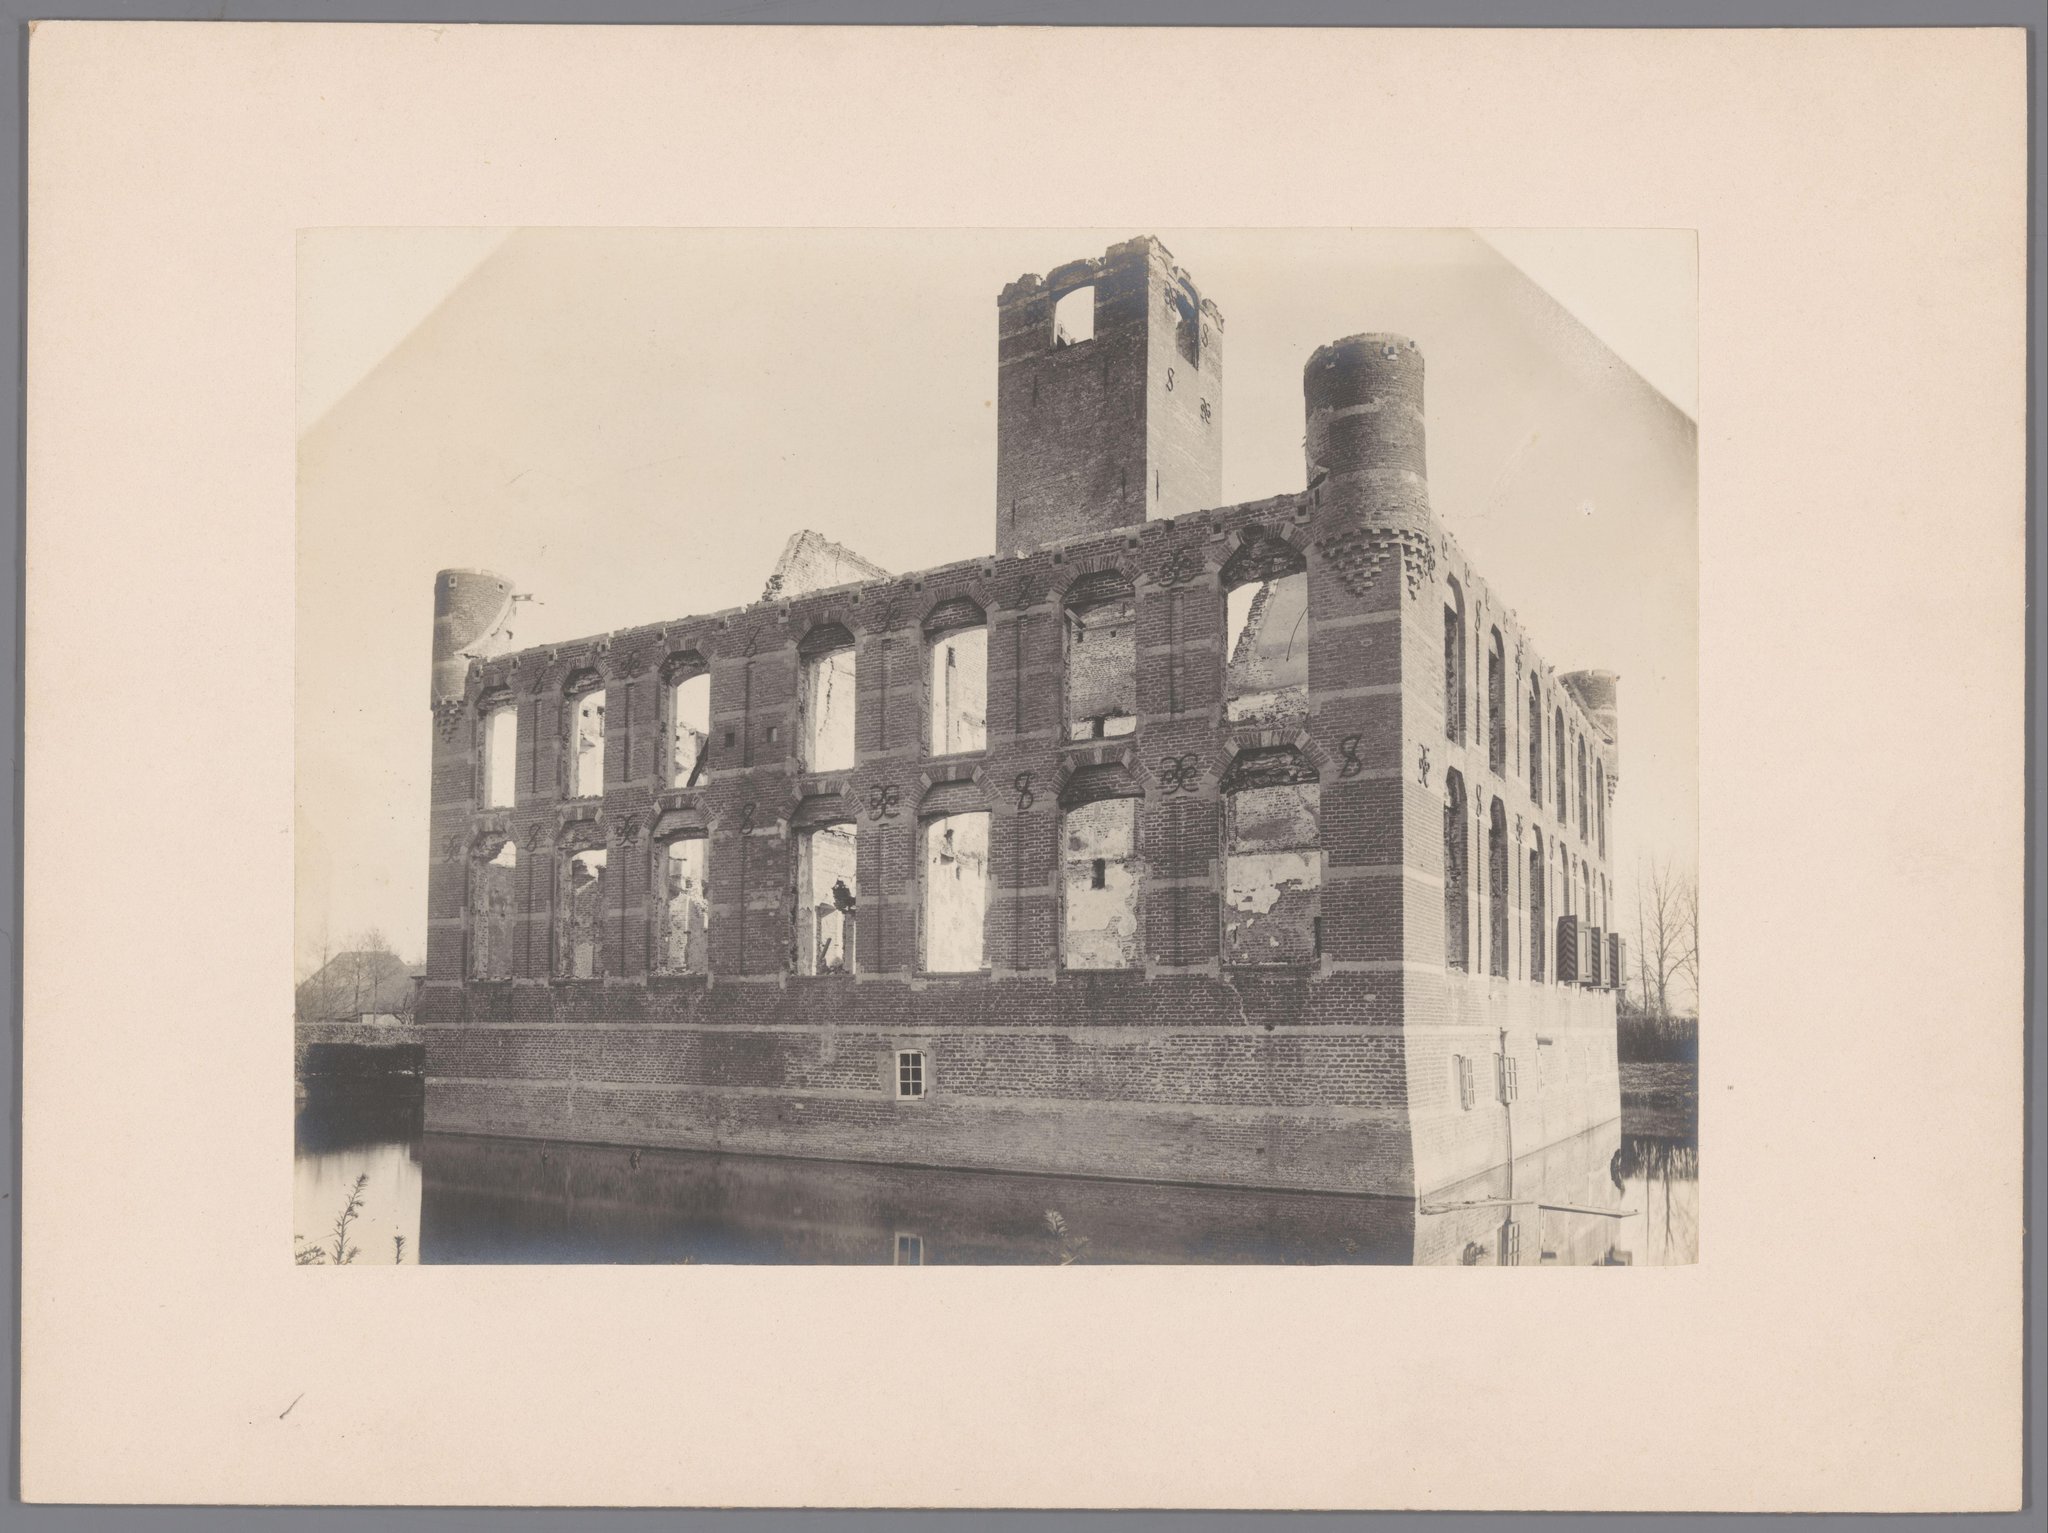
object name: photograph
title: Gezicht op het Kasteel van Wijchen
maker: anoniem (monumentenzorg)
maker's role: fotograaf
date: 1907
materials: cardboard, photographic support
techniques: gelatin silver print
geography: wijchen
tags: castle, landscape with tower or castle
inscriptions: annotation: ‘Kasteel te Wijchen achtergevel (G.)/ afgebrand Dec. 1906/ gephoto. Feb 1907’